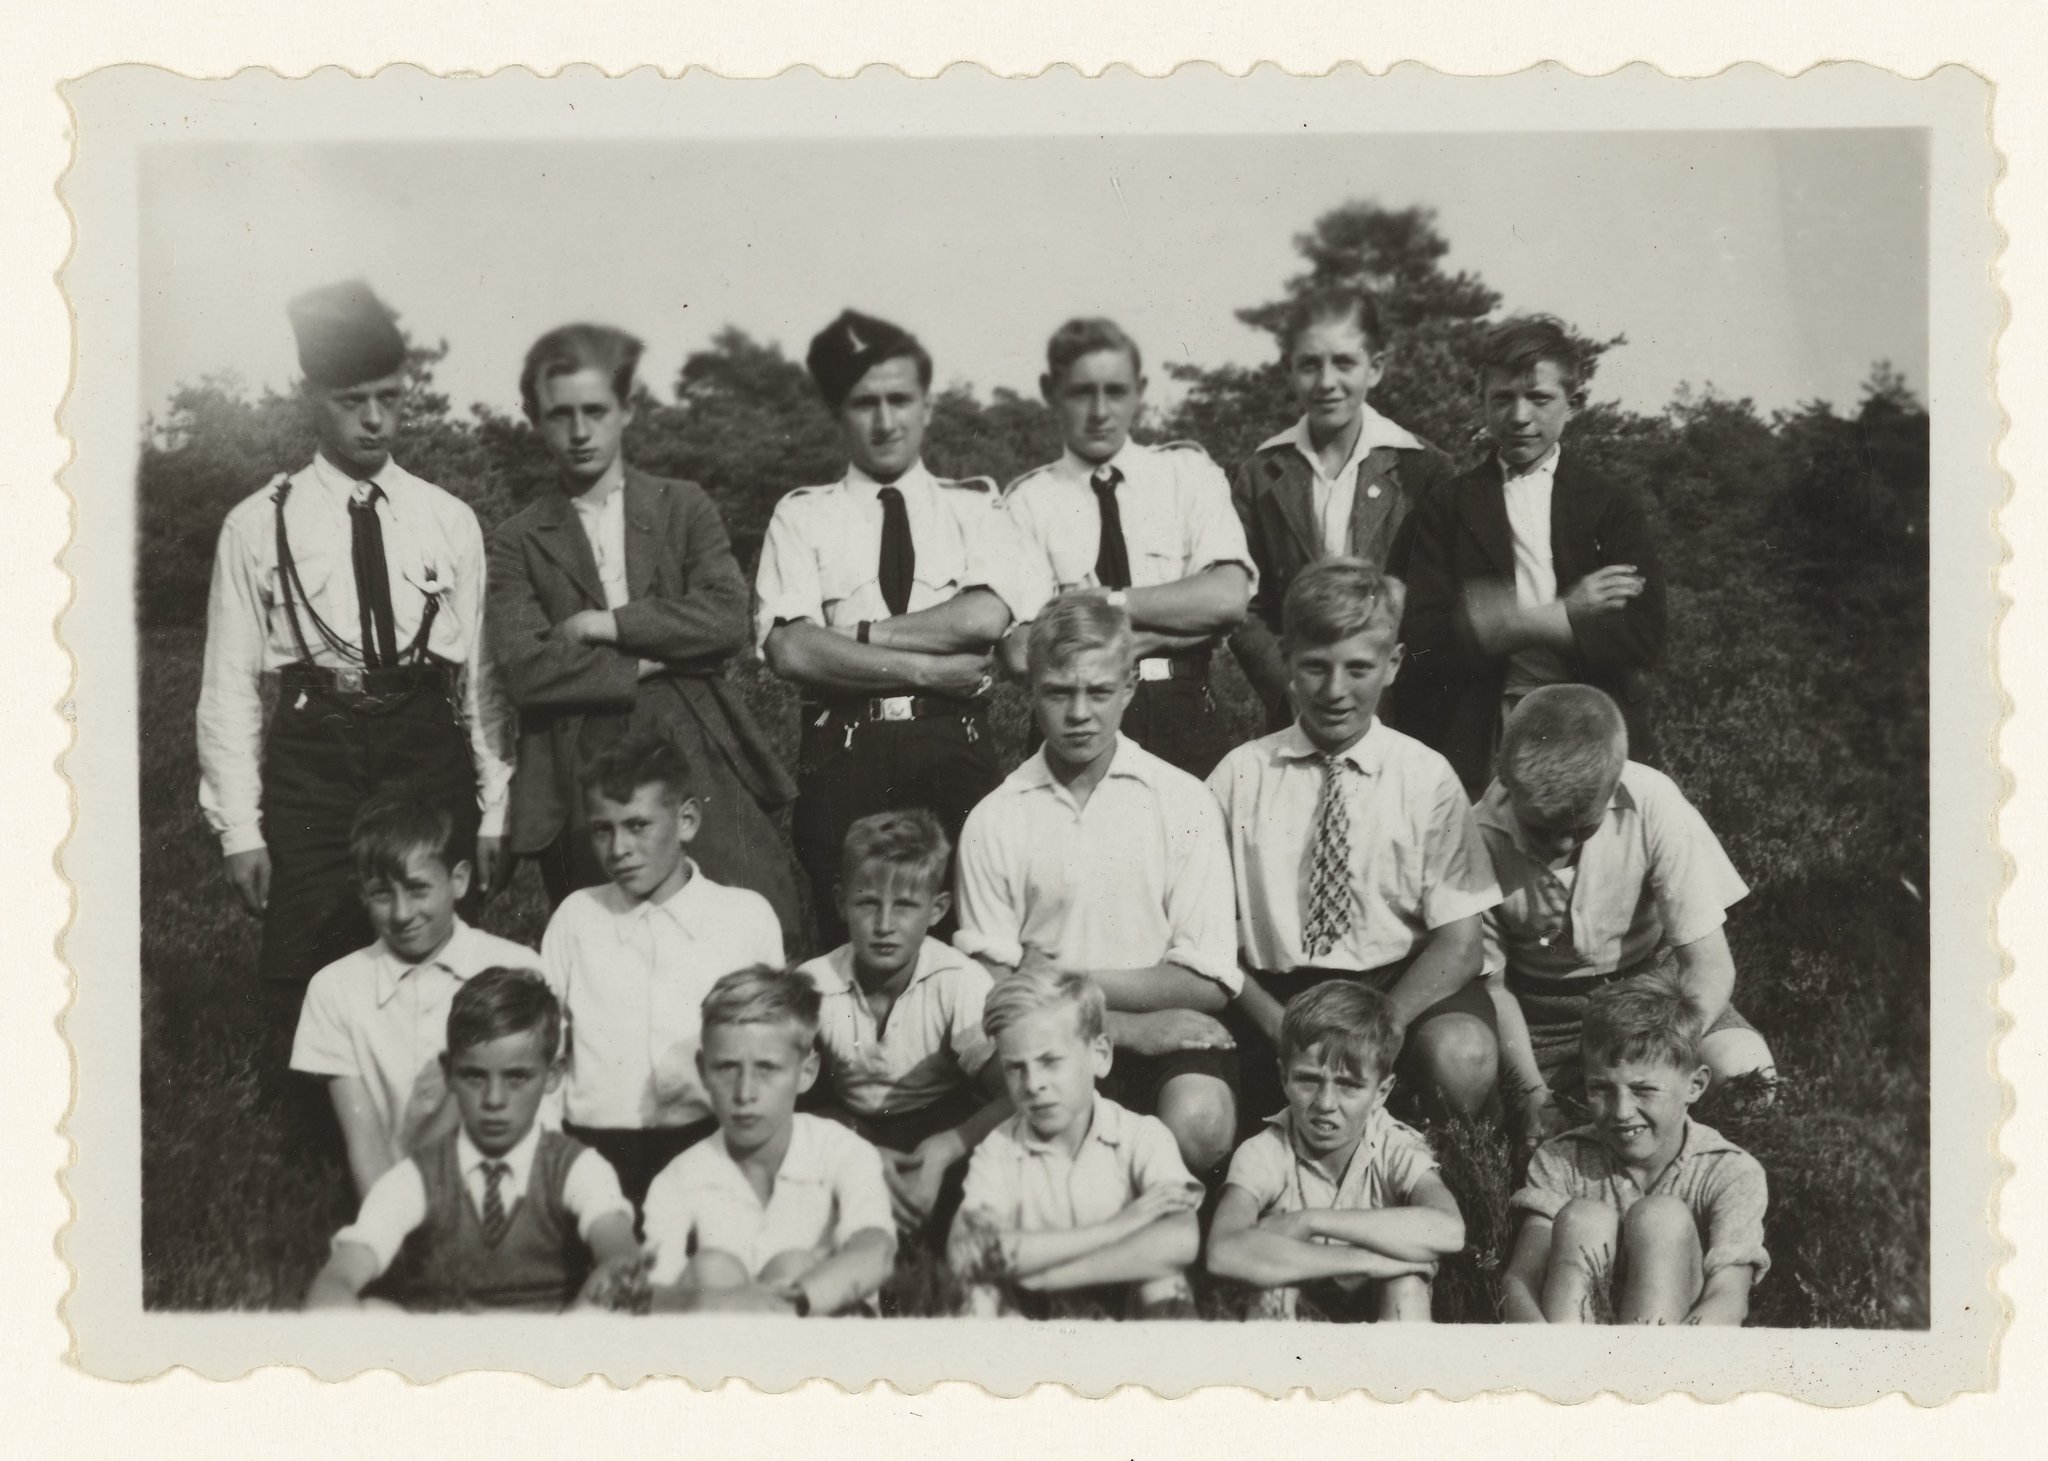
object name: photograph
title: Groep Jeugdstormers buiten geportretteerd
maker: Anonymous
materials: photographic support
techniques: photography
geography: bilthoven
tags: nsb, nationale jeugdstorm (njs), bilthoven, tweede wereldoorlog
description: Een groep jongens en een meisjes, deels in uniform van de (Nationale) Jeugdstorm, buiten geportretteerd, tijdens een jeugdkamp.